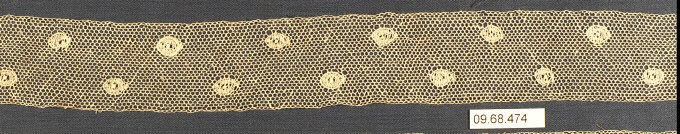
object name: insertion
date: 1801-1900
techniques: lace